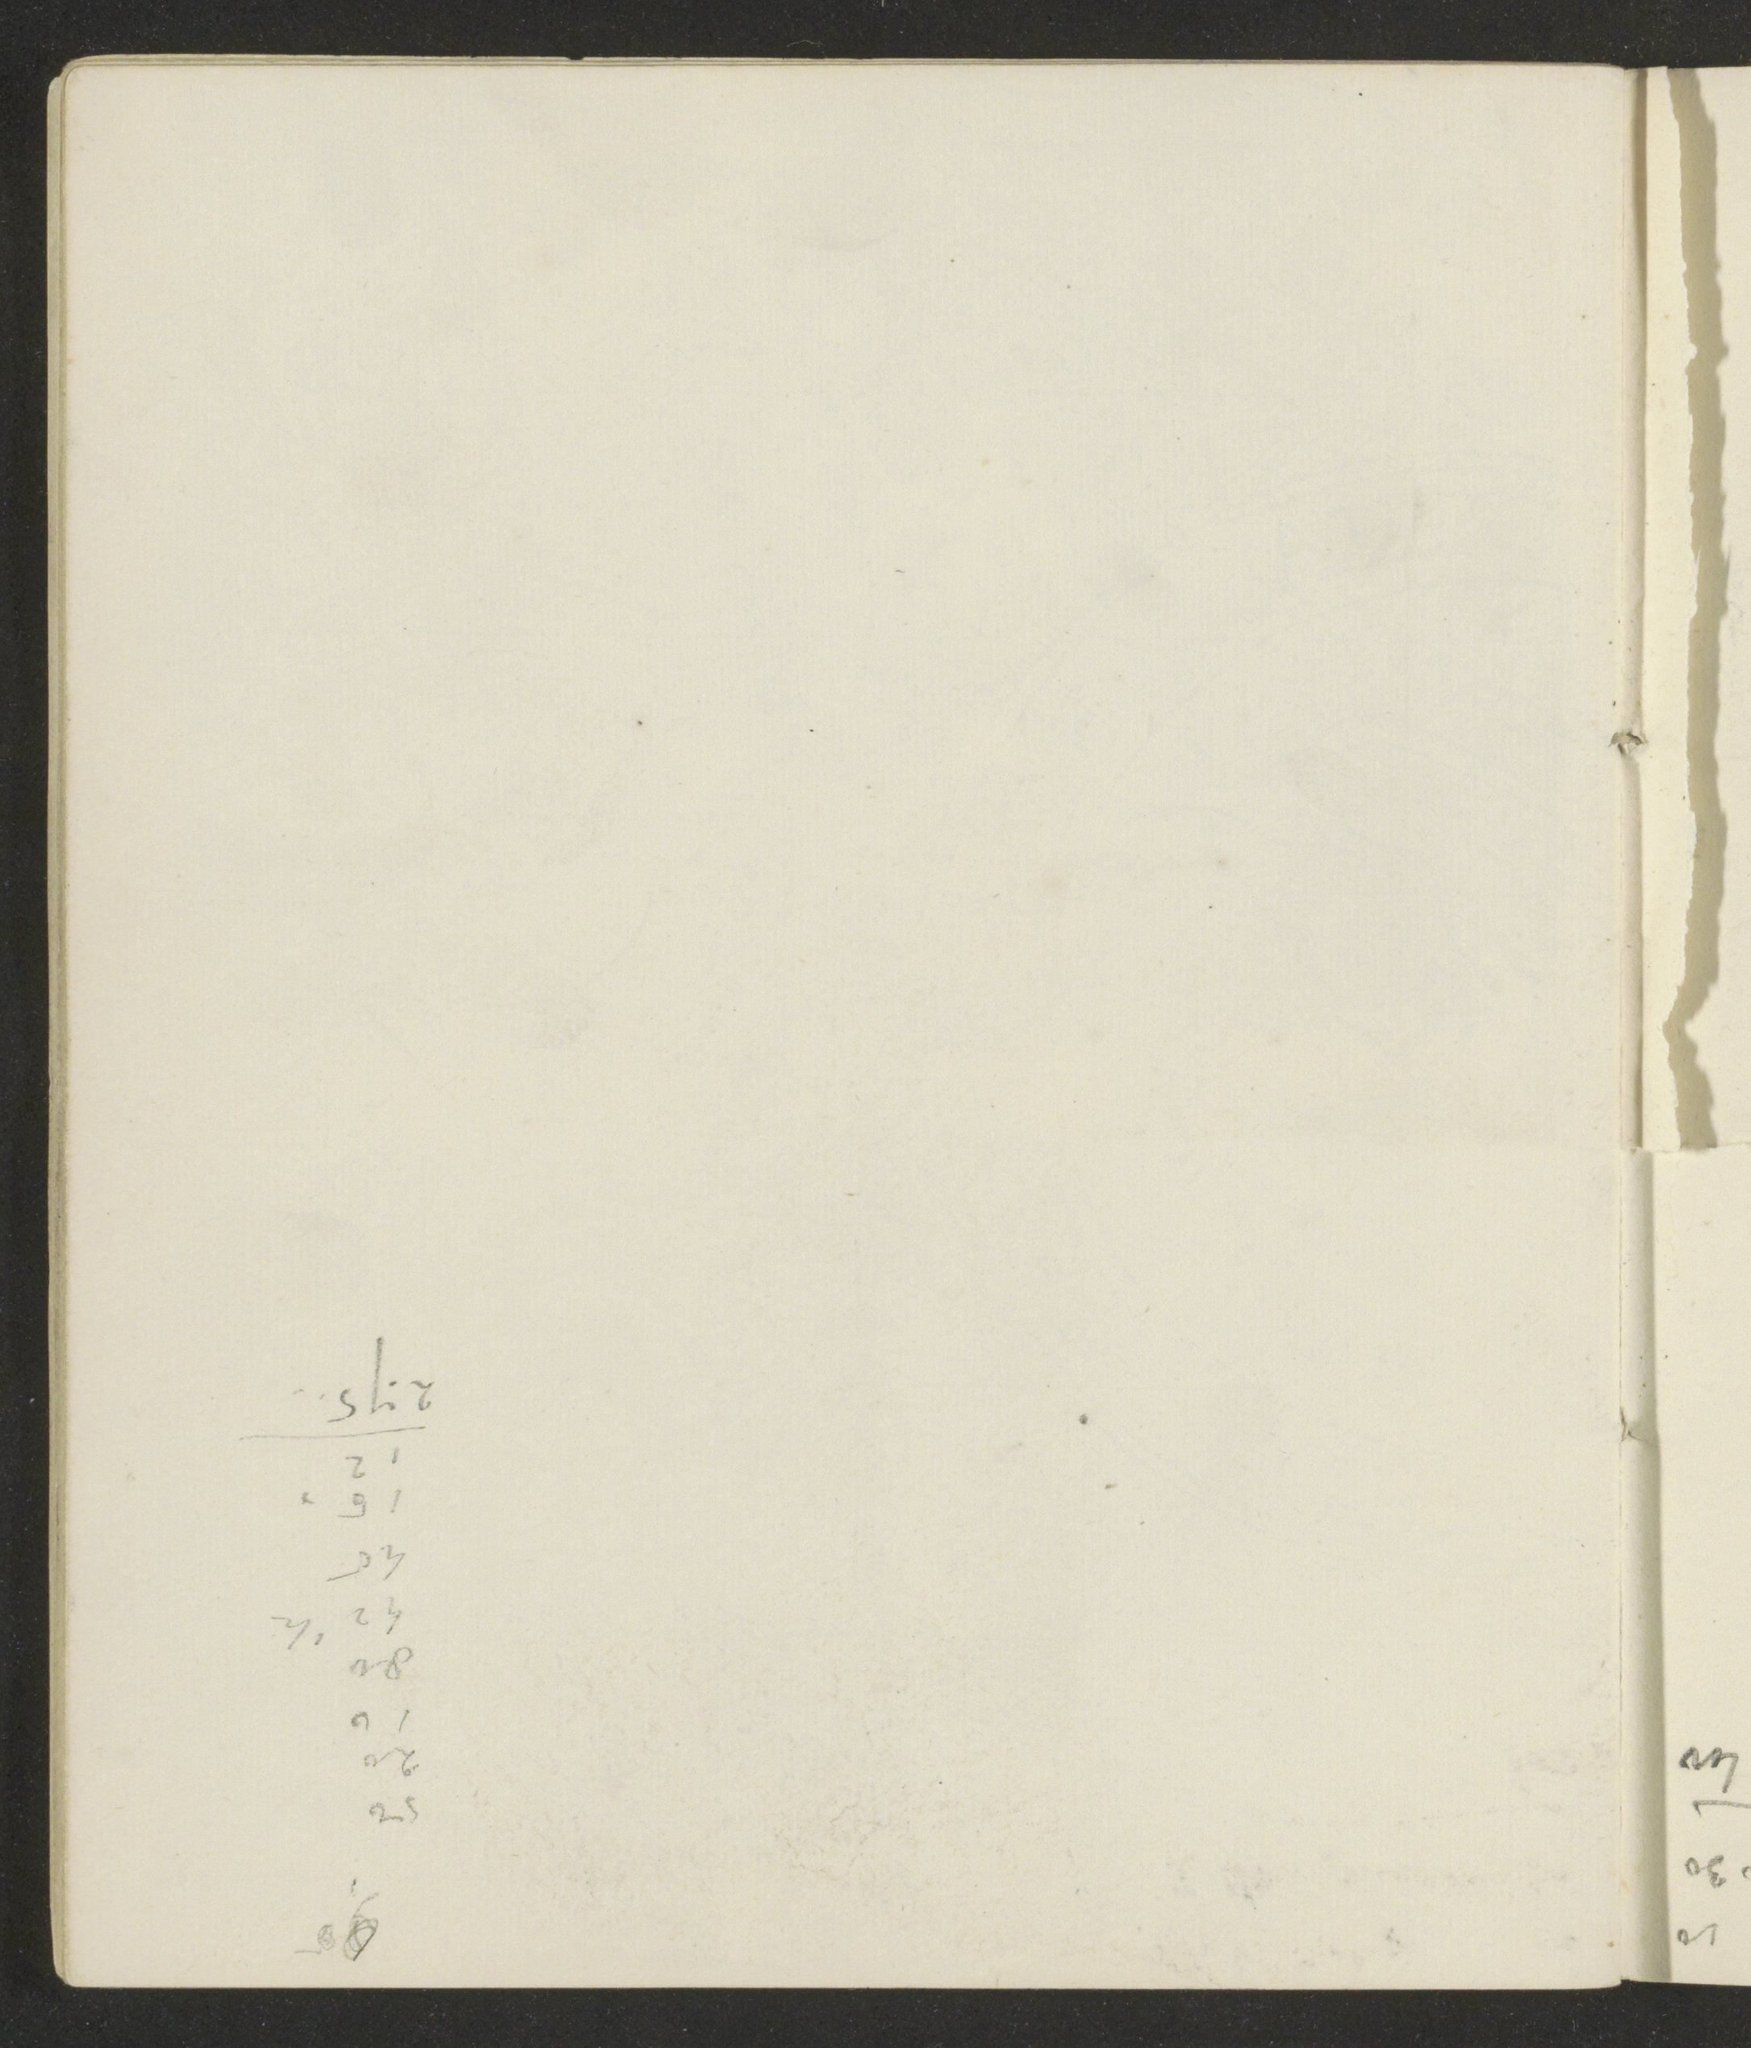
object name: sketchbook leaf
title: Berekening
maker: maria vos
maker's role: draughtsman, painter, print maker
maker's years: 1824-1906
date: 1858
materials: paper, pencil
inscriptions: annotation: ‘[...]’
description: Blad 17 verso uit een schetsboek met 19 bladen.